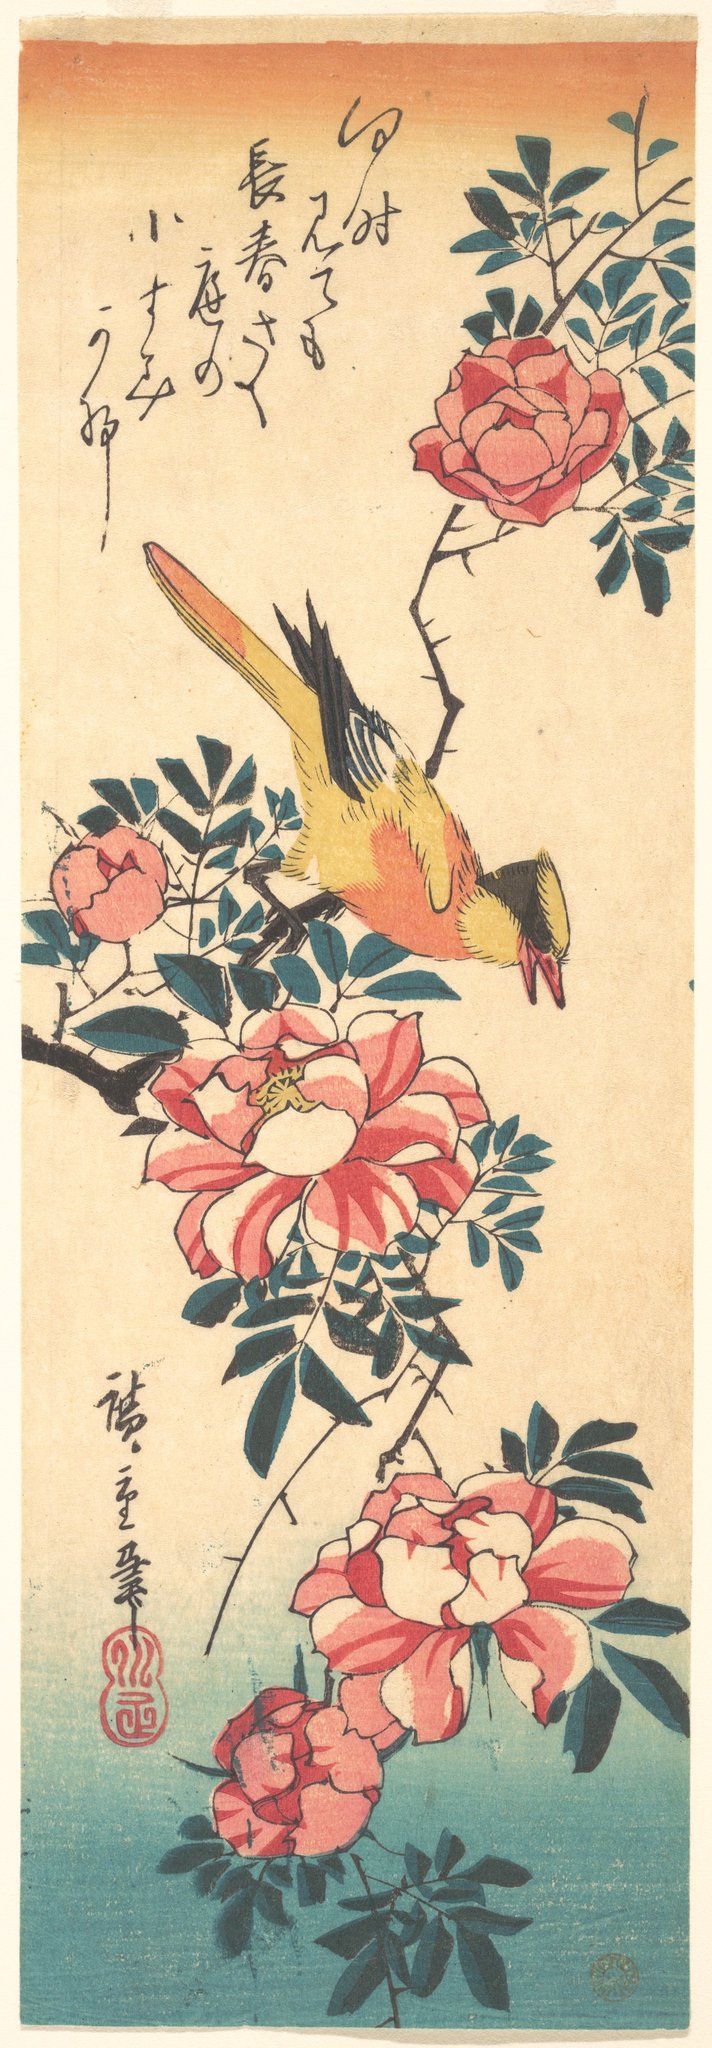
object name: print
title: Eastern Grey Wagtail and Rose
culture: japanese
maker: utagawa hiroshige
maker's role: artist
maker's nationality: japanese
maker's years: 1797-1858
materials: ink, paper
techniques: woodblock print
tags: birds,roses